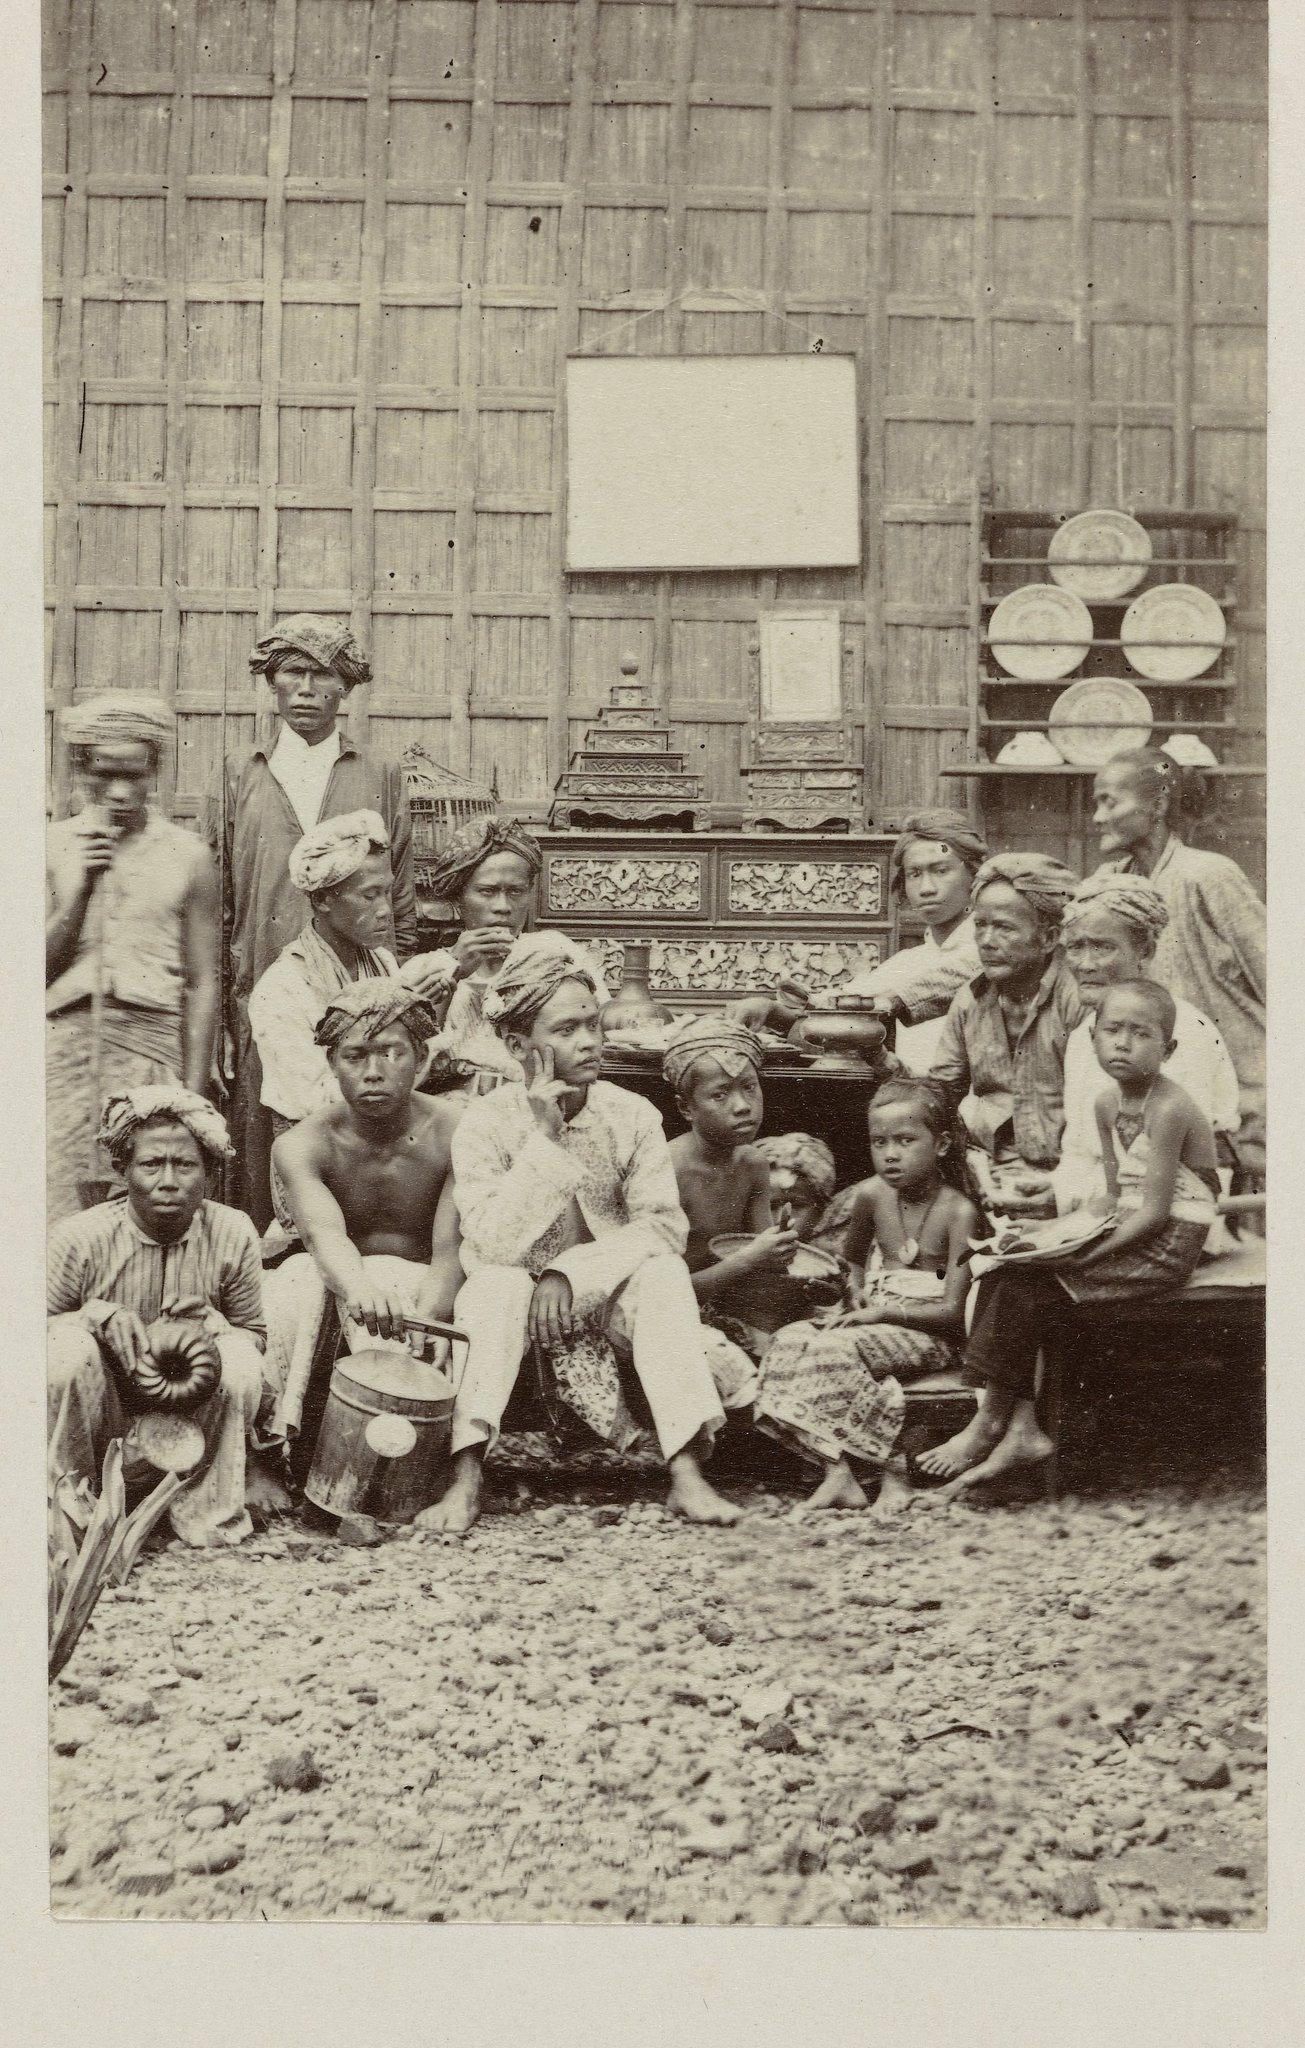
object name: photograph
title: Maleisische bedienden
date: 1860-1872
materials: photographic support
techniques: albumen print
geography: celebes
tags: house personnel, servants, java, batavia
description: Portret van een groep Maleisische bedienden, waarschijnlijk die van de fotografen Woodbury & Page zelf. Ingeplakte foto in het fotoalbum getiteld: Gezichten van Java.